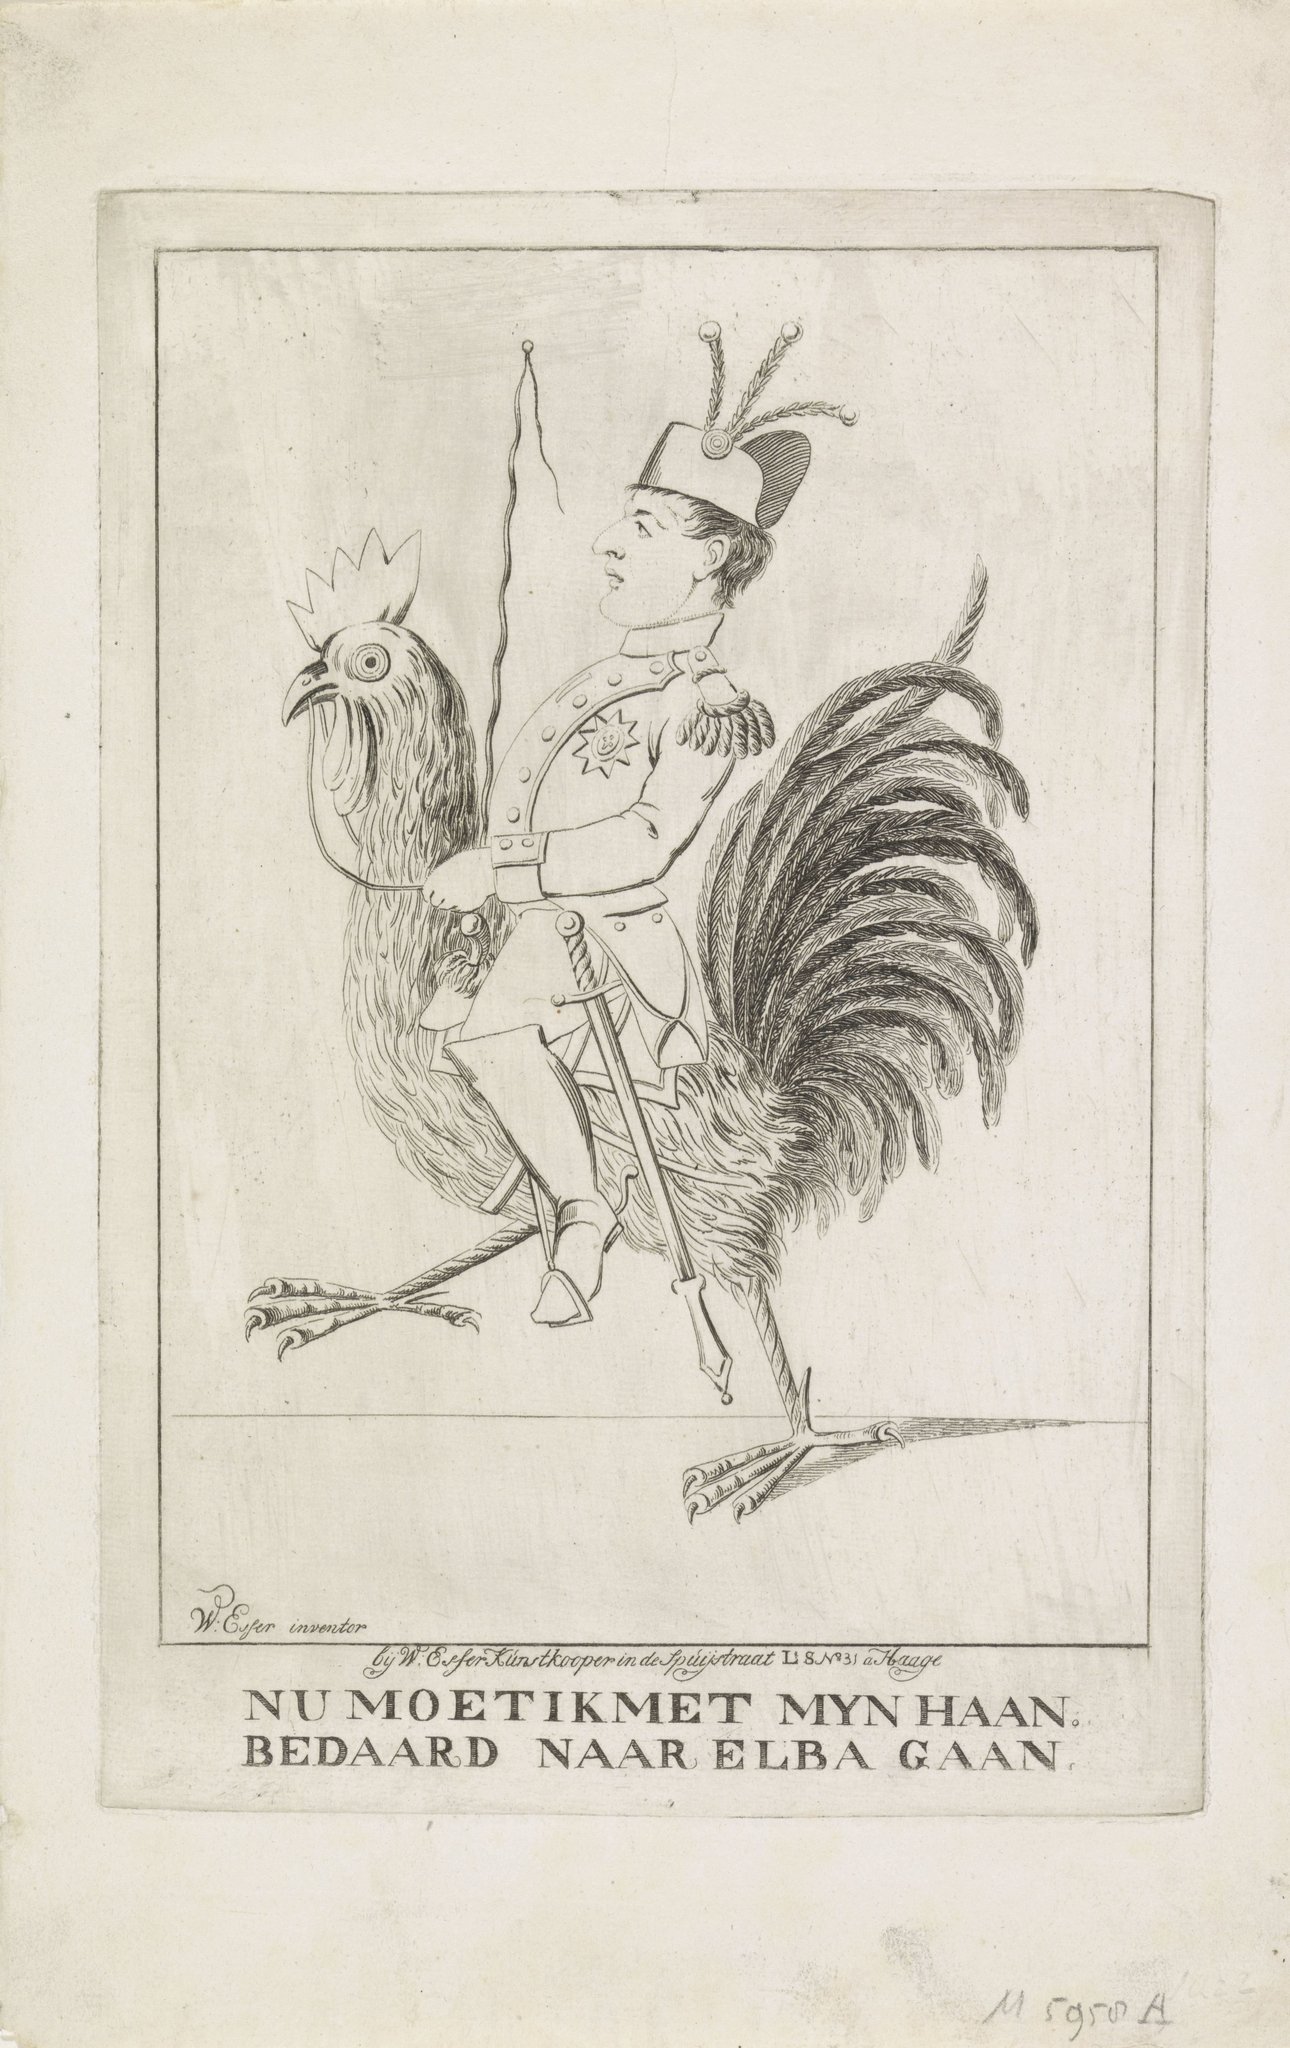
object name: cartoon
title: Nu moet ik met myn Haan, bedaard naar Elba gaan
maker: wijnand esser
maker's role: draughtsman, print maker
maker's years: 1779-1860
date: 1814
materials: paper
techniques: engraving, etching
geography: the hague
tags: napoleon i (emperor of the french), riding on animal other than horse, ass, or mule, fowl (cock, hen, chicken, etc.)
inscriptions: collector's mark: Lugt 2228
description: Spotprent op de verbanning van Napoleon naar Elba, mei 1814. Napoleon berijdt de Franse Haan.